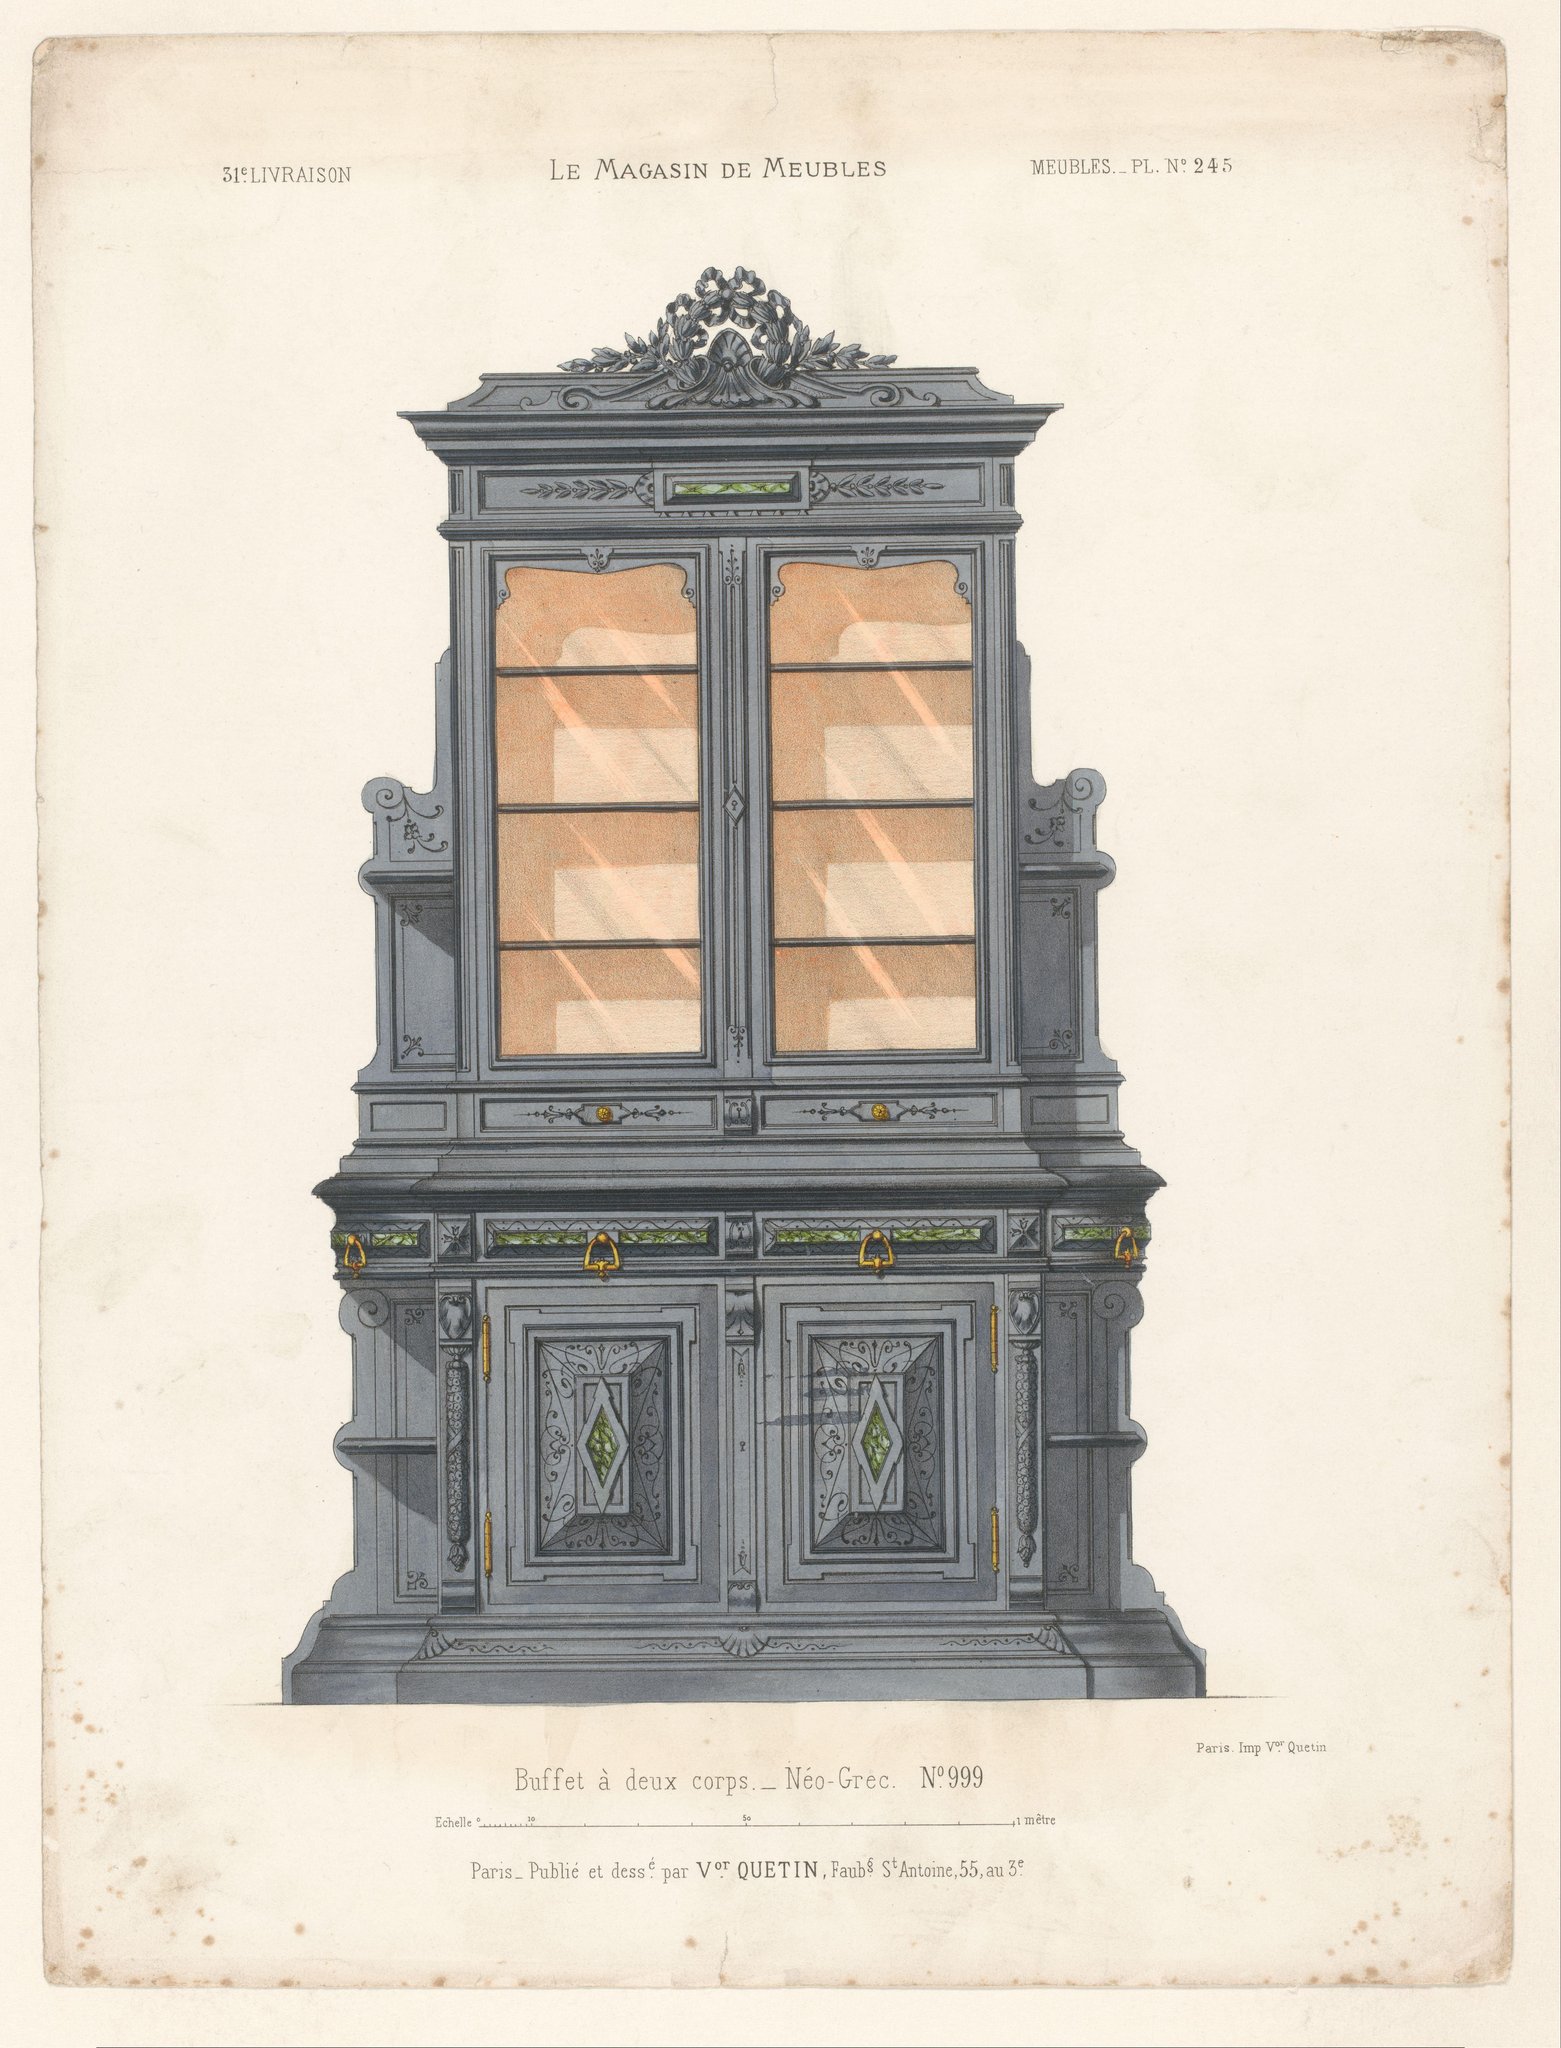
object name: print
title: Buffet à deux corps. Néo-Grec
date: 1832-1877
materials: paper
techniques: hand coloring, lithograph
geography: paris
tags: furniture for storage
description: Een buffetkast in de stijl van de neo-grec. Prent uit 31e Livraison.